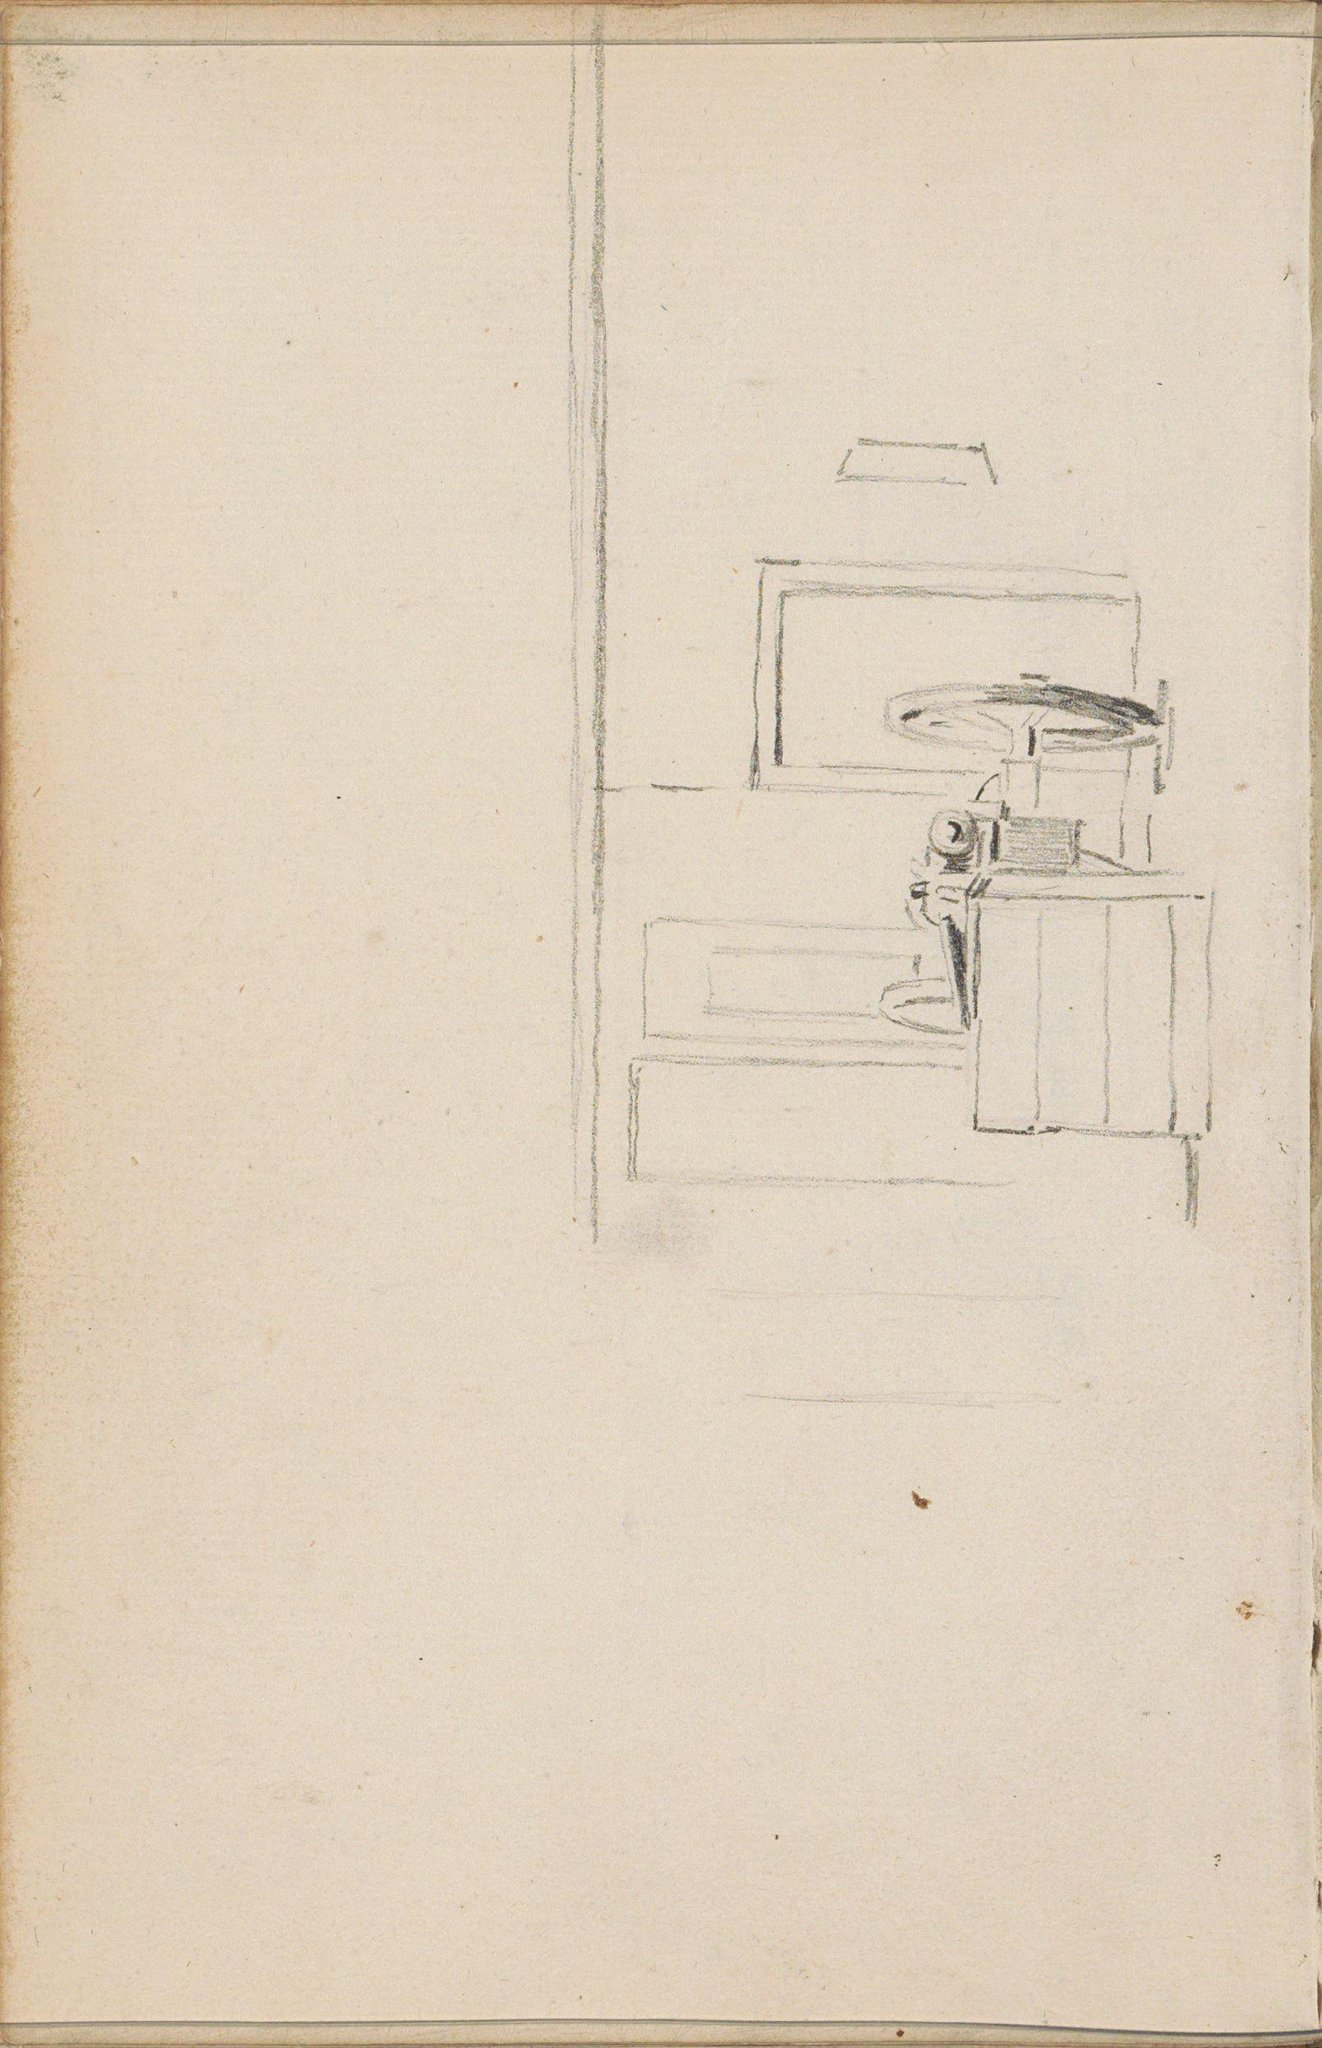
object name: sketchbook leaf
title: Machine bestaande uit twee wielen en een kist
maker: jacob perkois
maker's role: draughtsman, print maker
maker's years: 1756-1804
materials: paper, pencil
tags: machines; parts of machines; tools and appliances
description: Bladzijde 16 uit een schetsboek met 78 bladzijden.